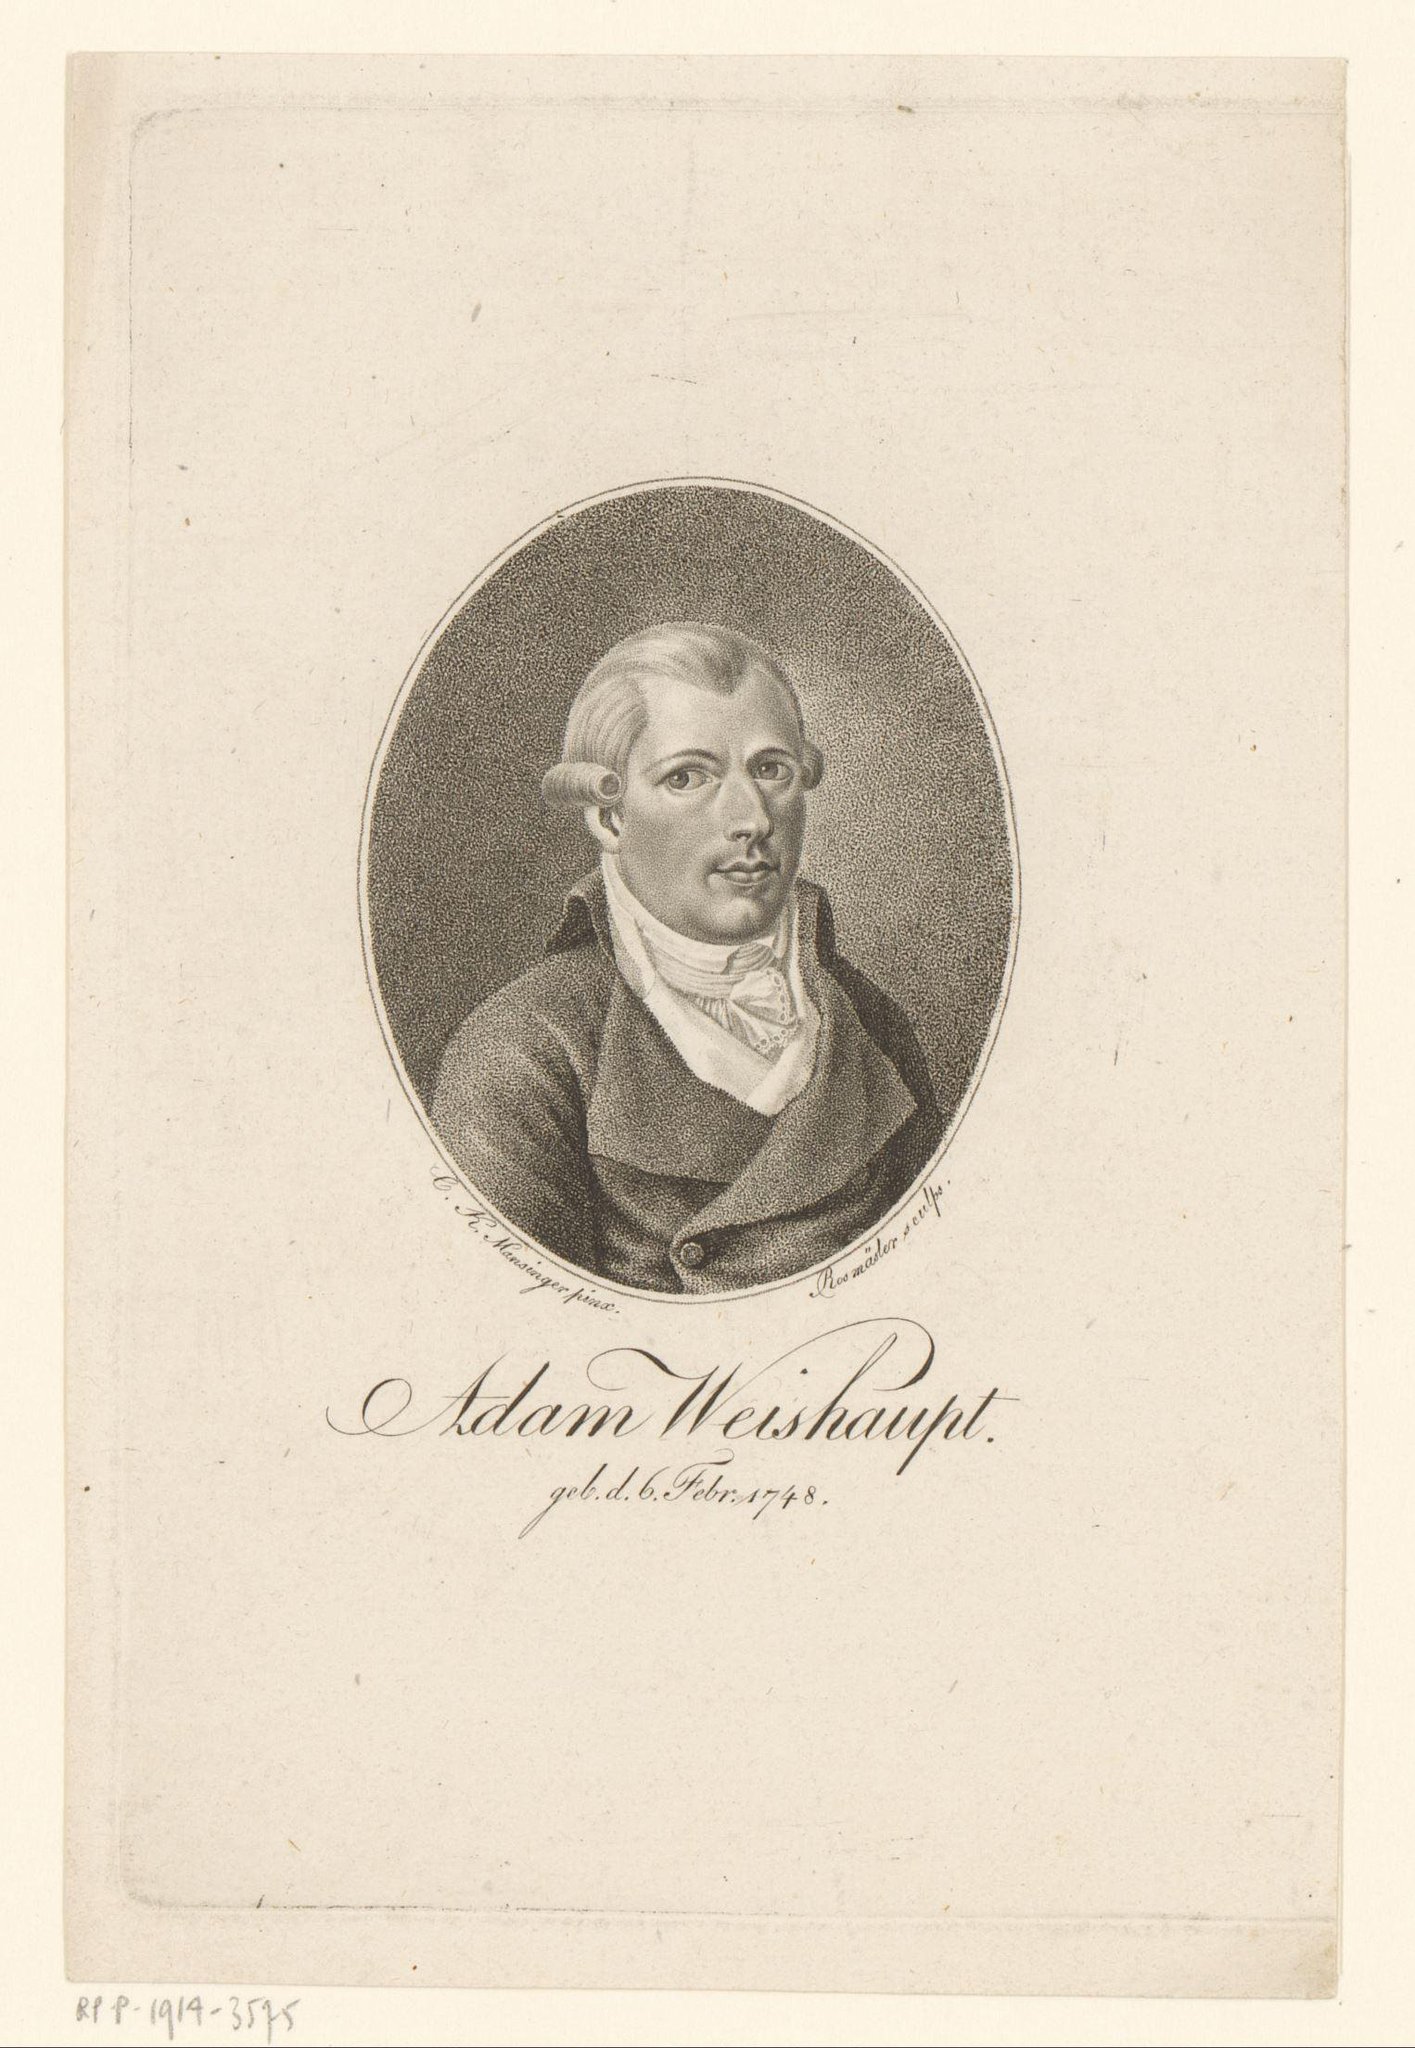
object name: print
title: Portret van Adam Weishaupt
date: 1785-1858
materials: paper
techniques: engraving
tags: historical persons, portrait of a writer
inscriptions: collector's mark: Lugt 2228